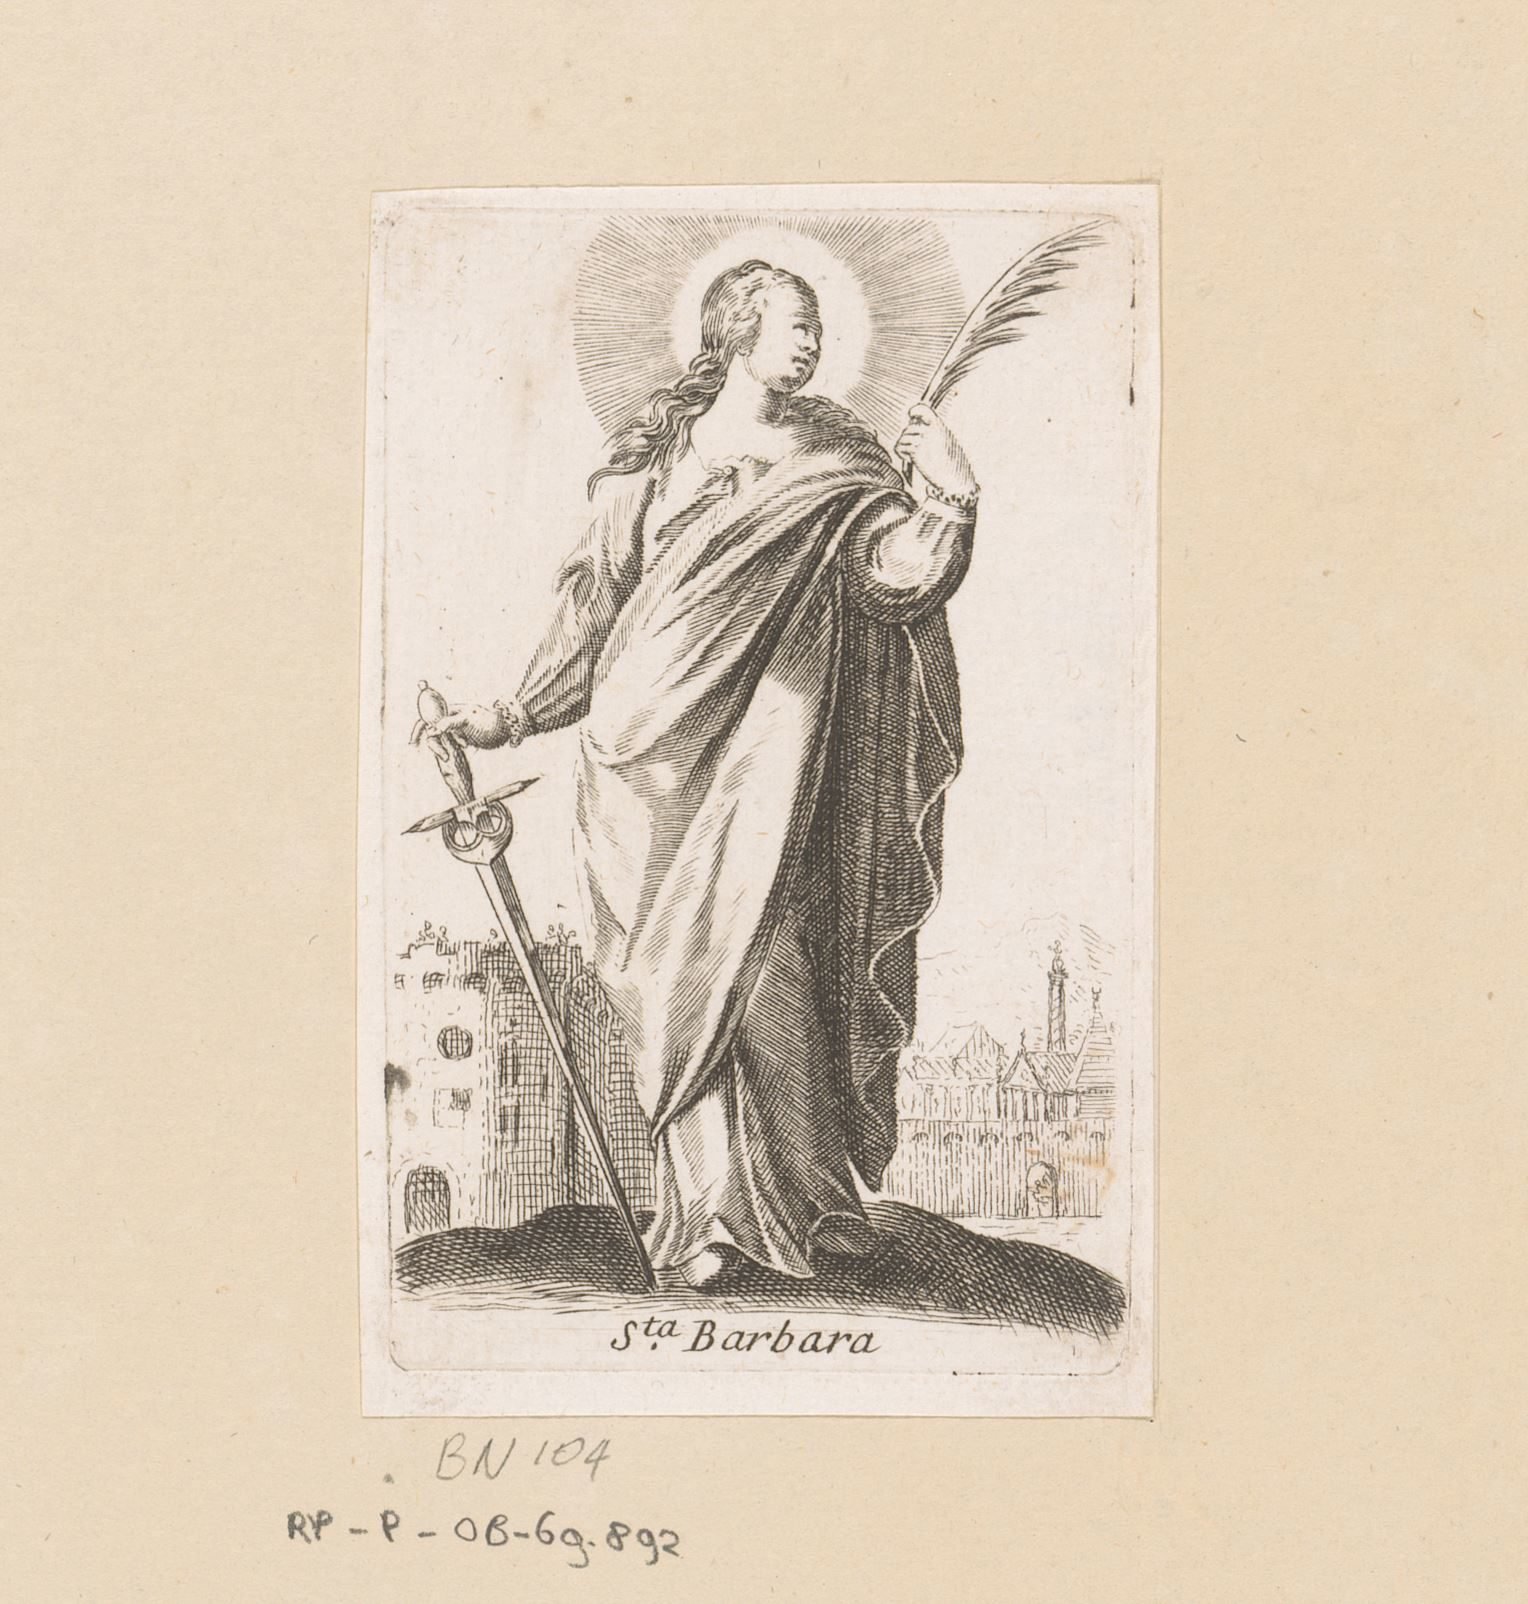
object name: print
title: H. Barbara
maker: claude mellan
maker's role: draughtsman, print maker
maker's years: 1598-1688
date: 1608-1688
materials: paper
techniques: engraving, etching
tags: the virgin martyr barbara; possible attributes: book, cannon(ball), crown, cross, chalice with wafer, dioscuros (her father), peacock feather, sword, torches, mason's tools, tower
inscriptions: collector's mark: Lugt 240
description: Maakt mogelijk deel uit van een serie met verschillende heiligen.